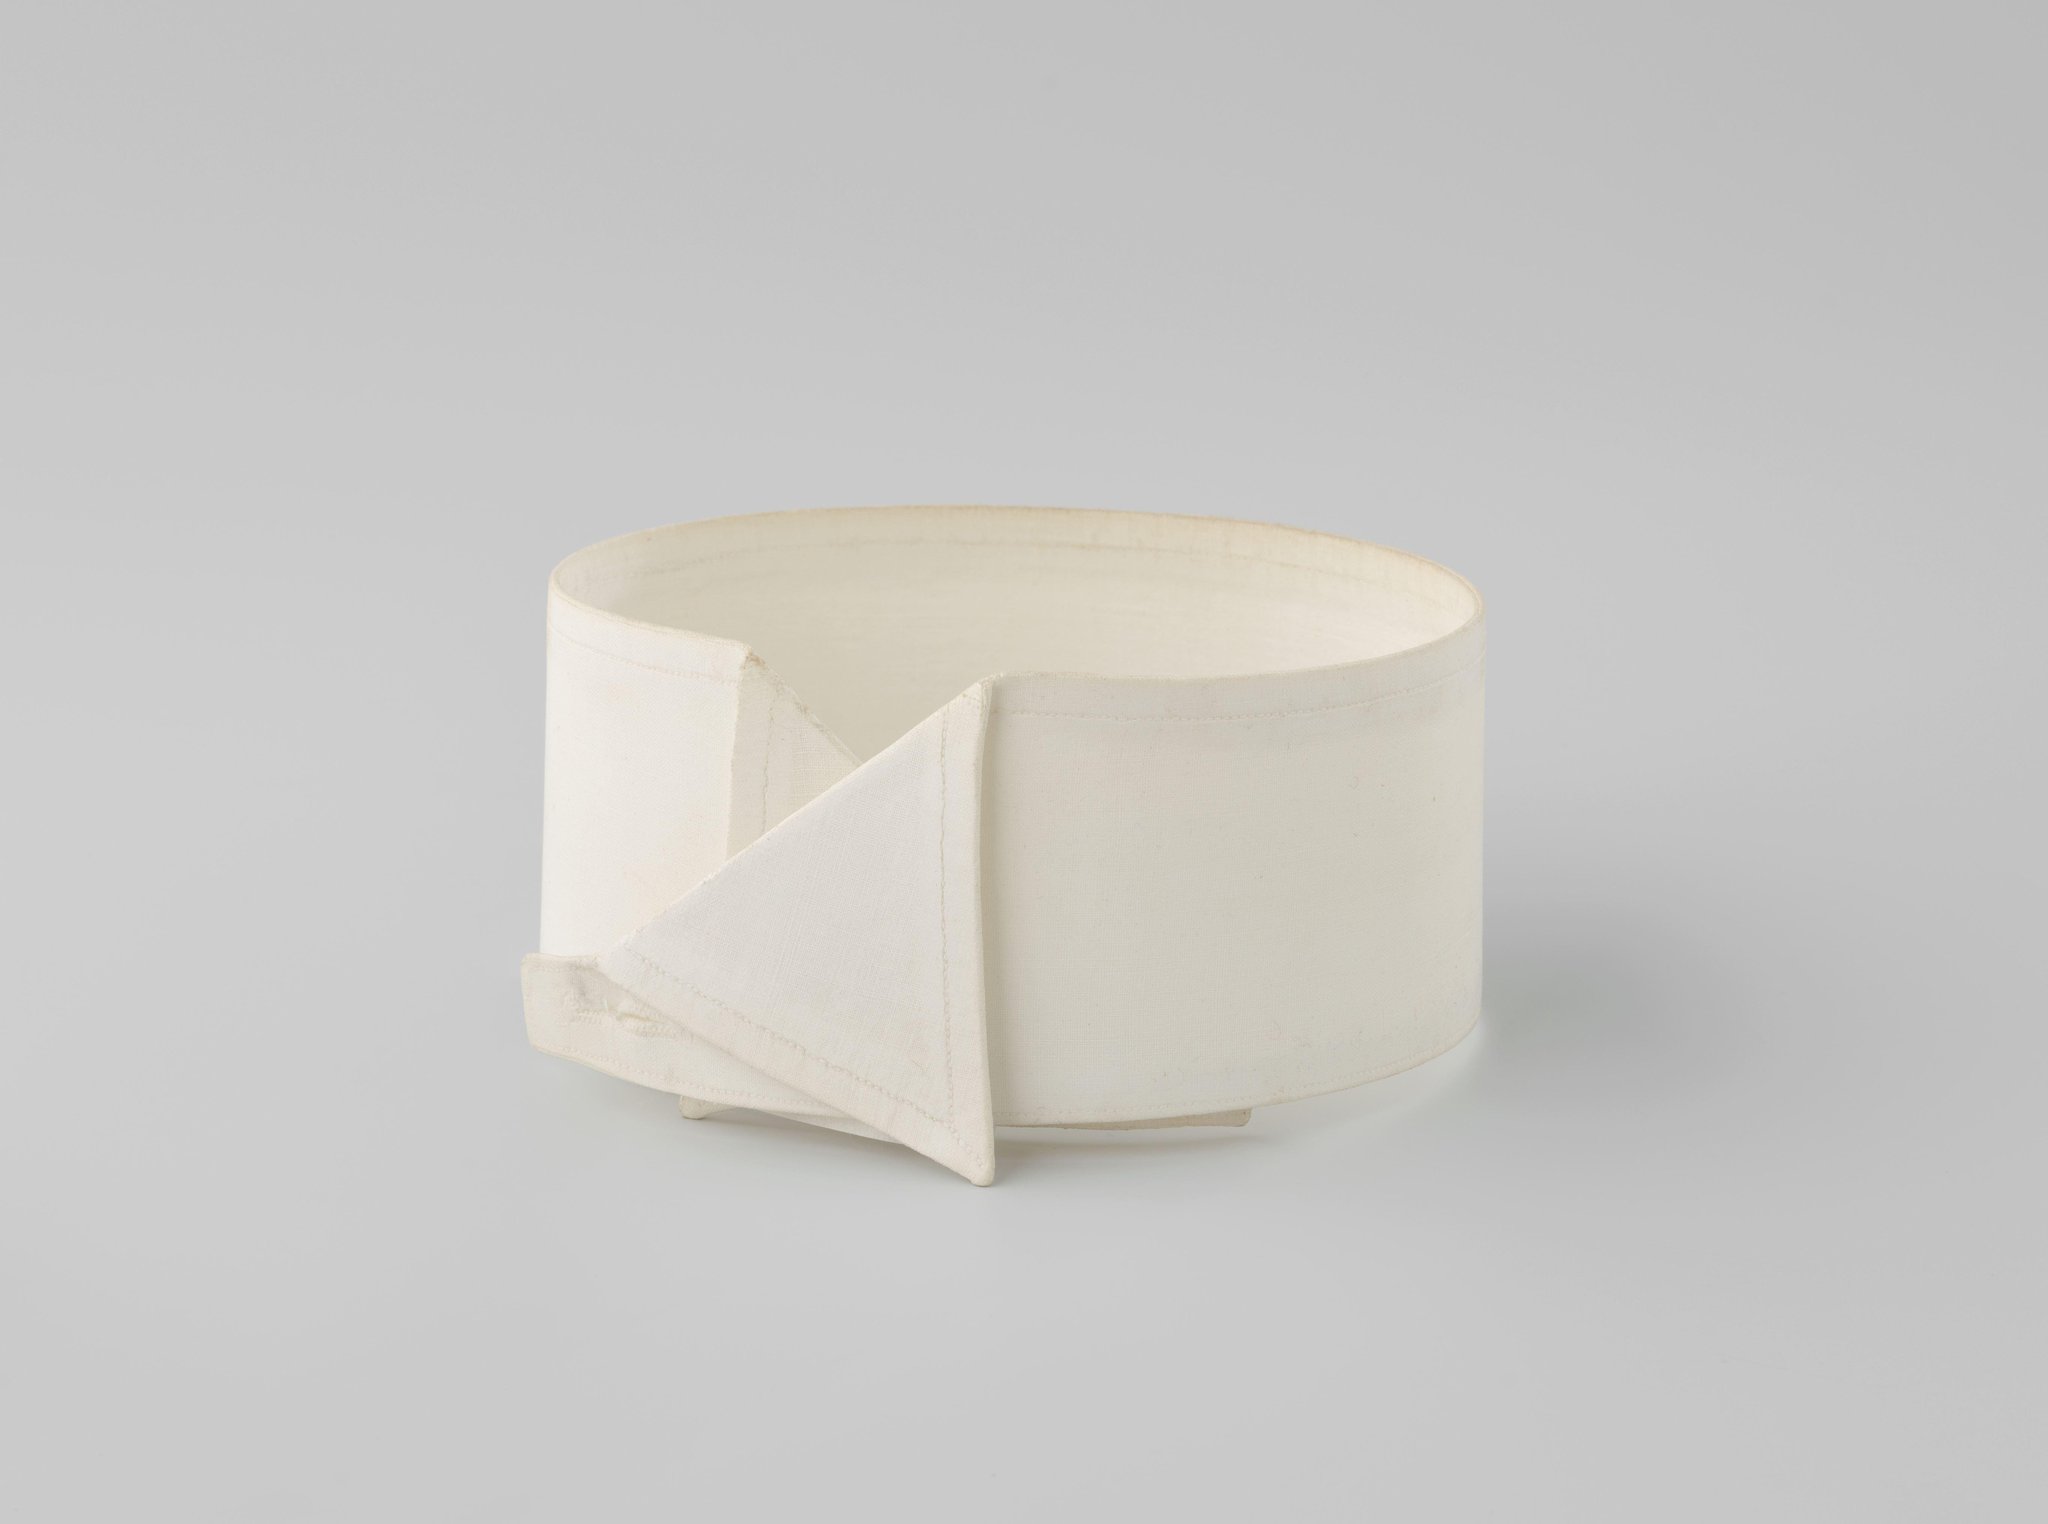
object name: collar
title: Vadermoordenaar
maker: Anonymous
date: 1850-1920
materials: textile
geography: netherlands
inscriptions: number: ‘247’